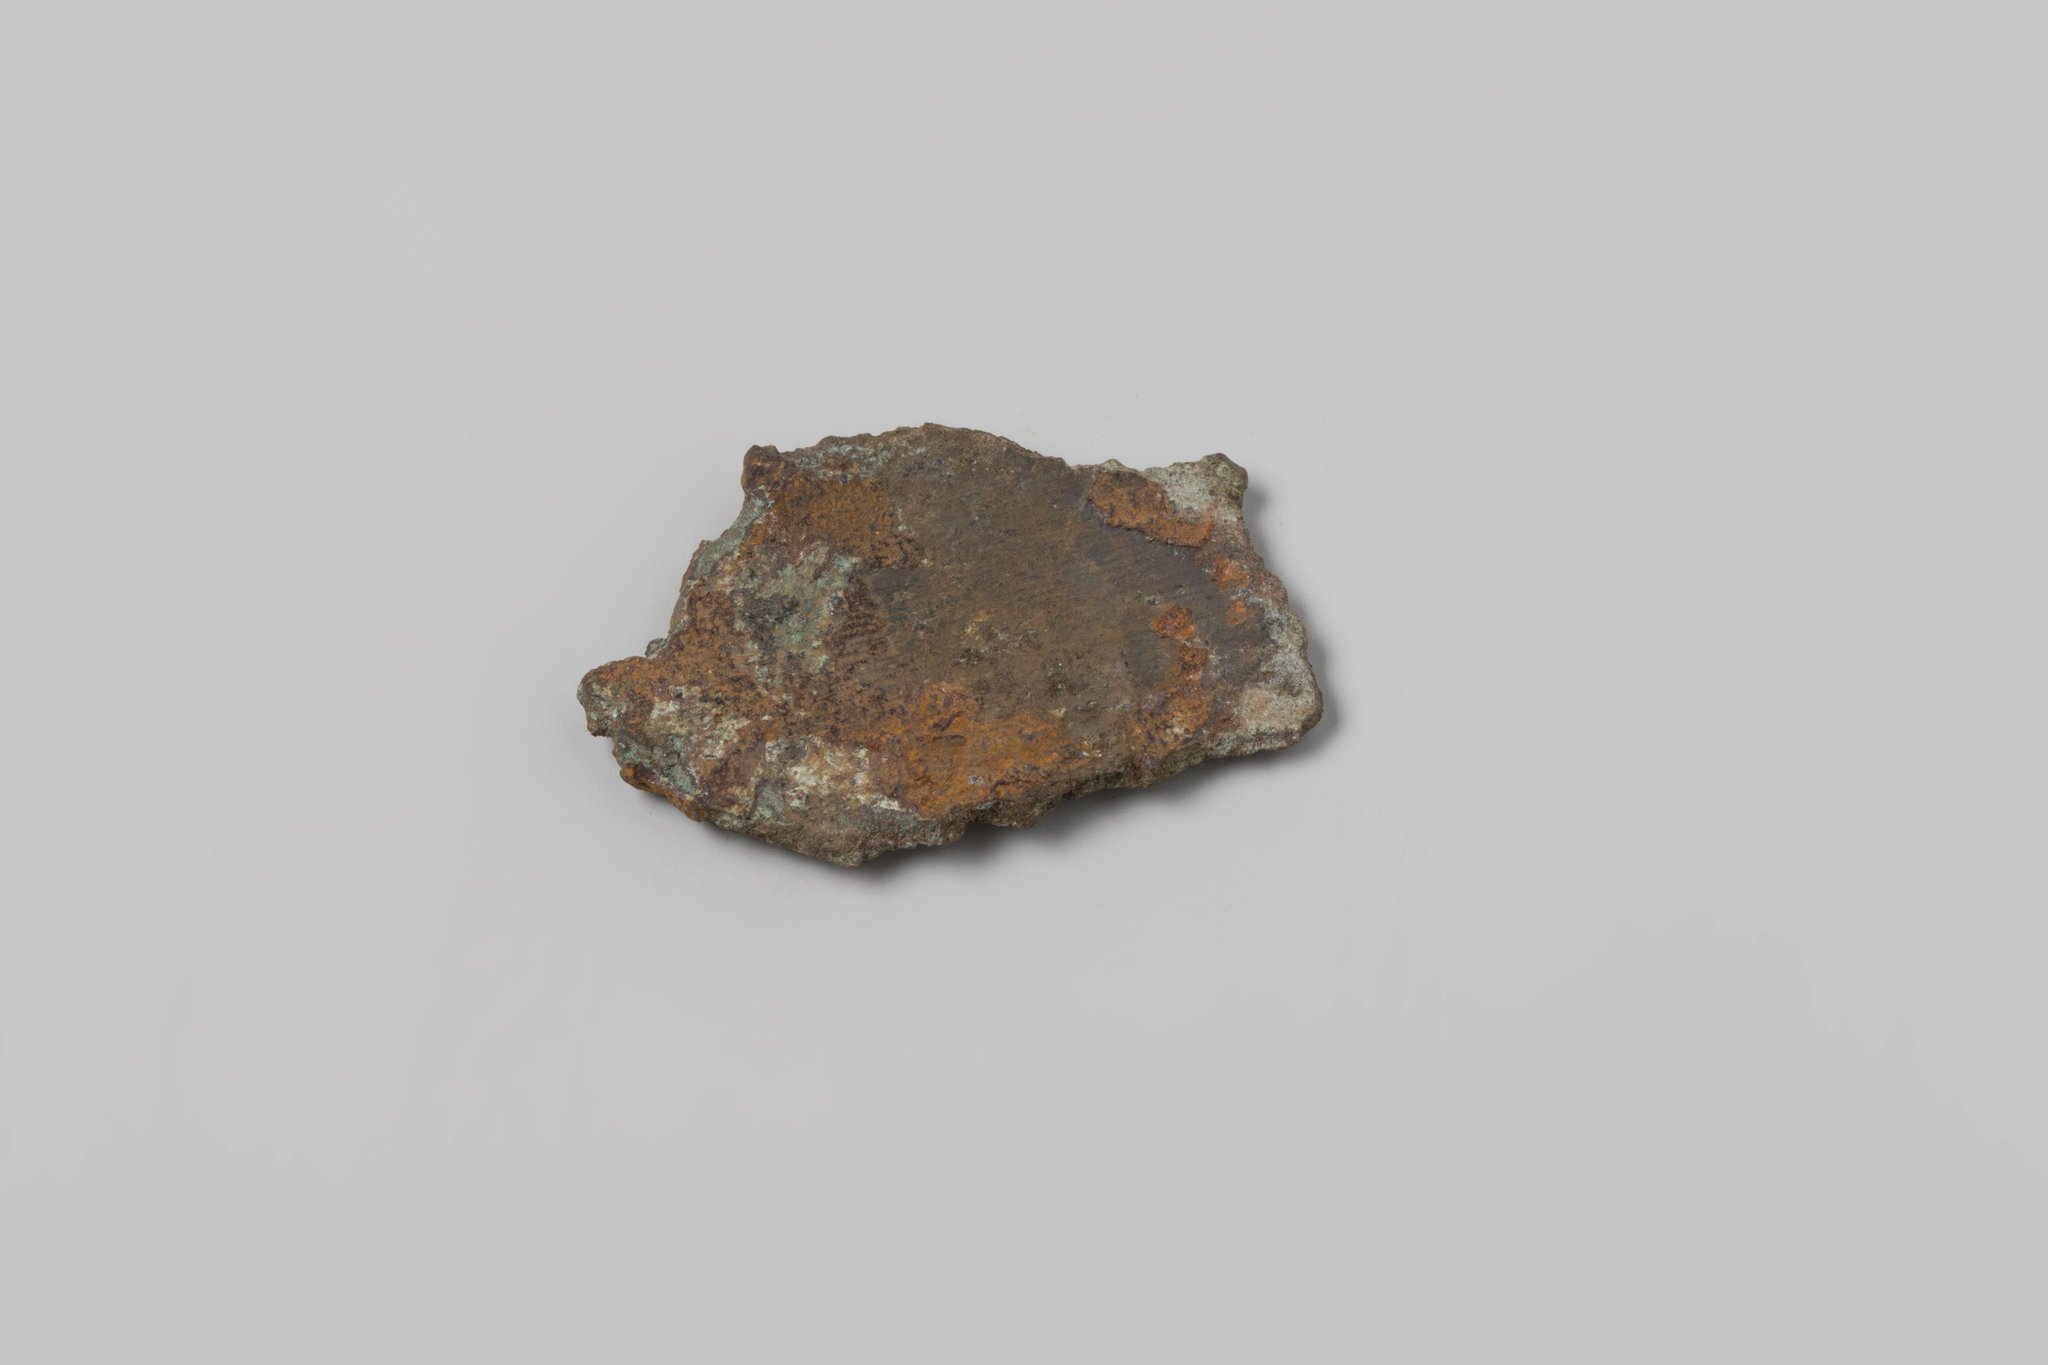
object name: fragment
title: Fragment koper uit het wrak van de Oost-Indiëvaarder Hollandia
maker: Anonymous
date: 1700-1743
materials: copper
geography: netherlands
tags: verenigde oostindische compagnie, hollandia (schip), annet